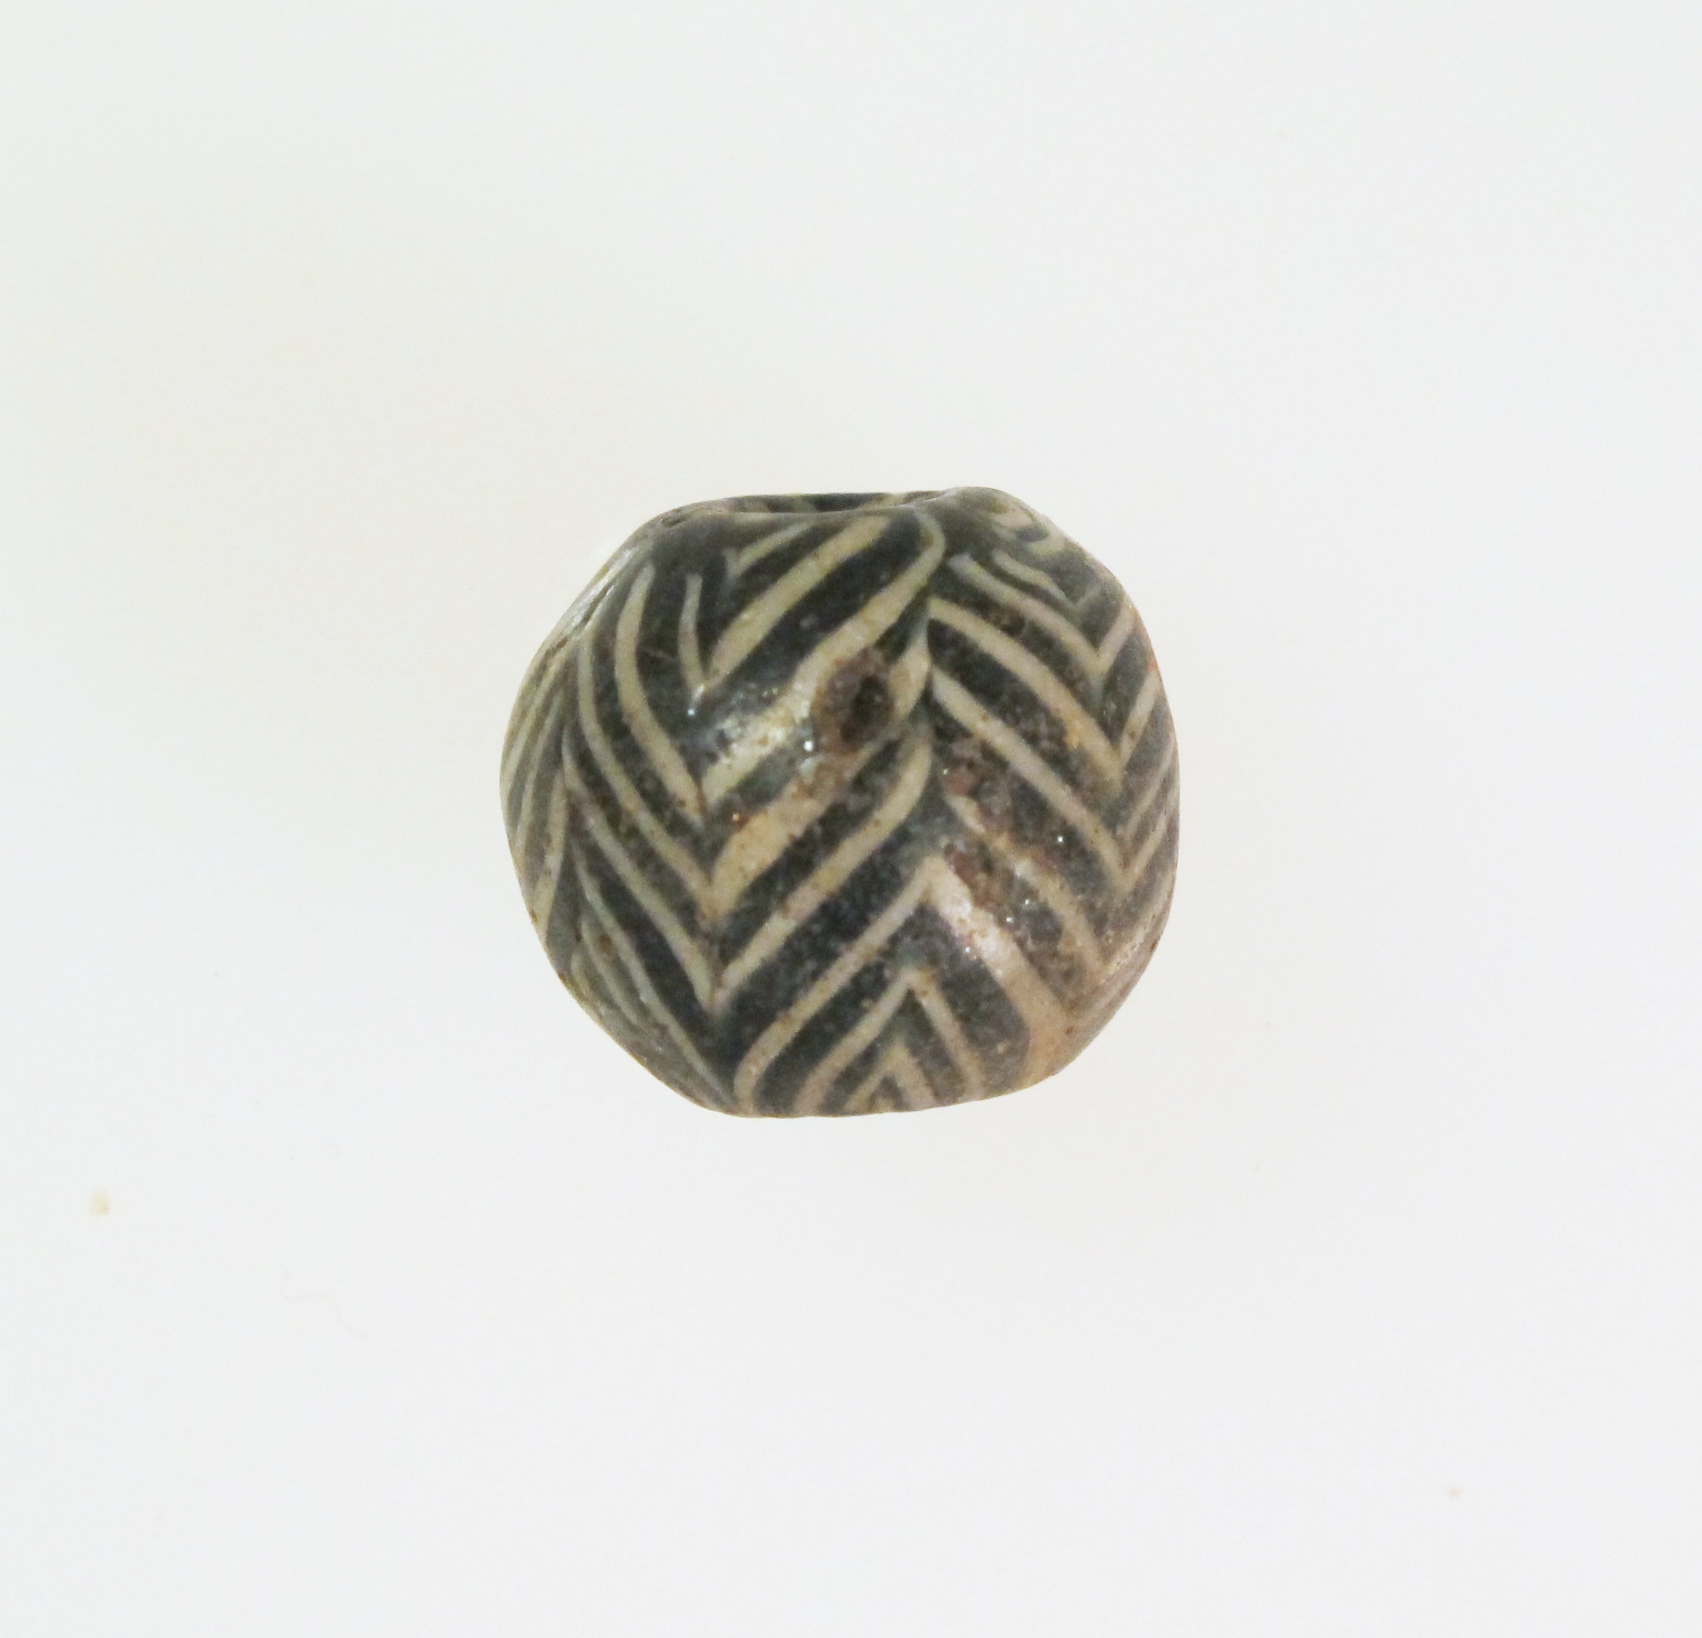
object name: bead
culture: roman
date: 670 BCE-330 CE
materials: glass